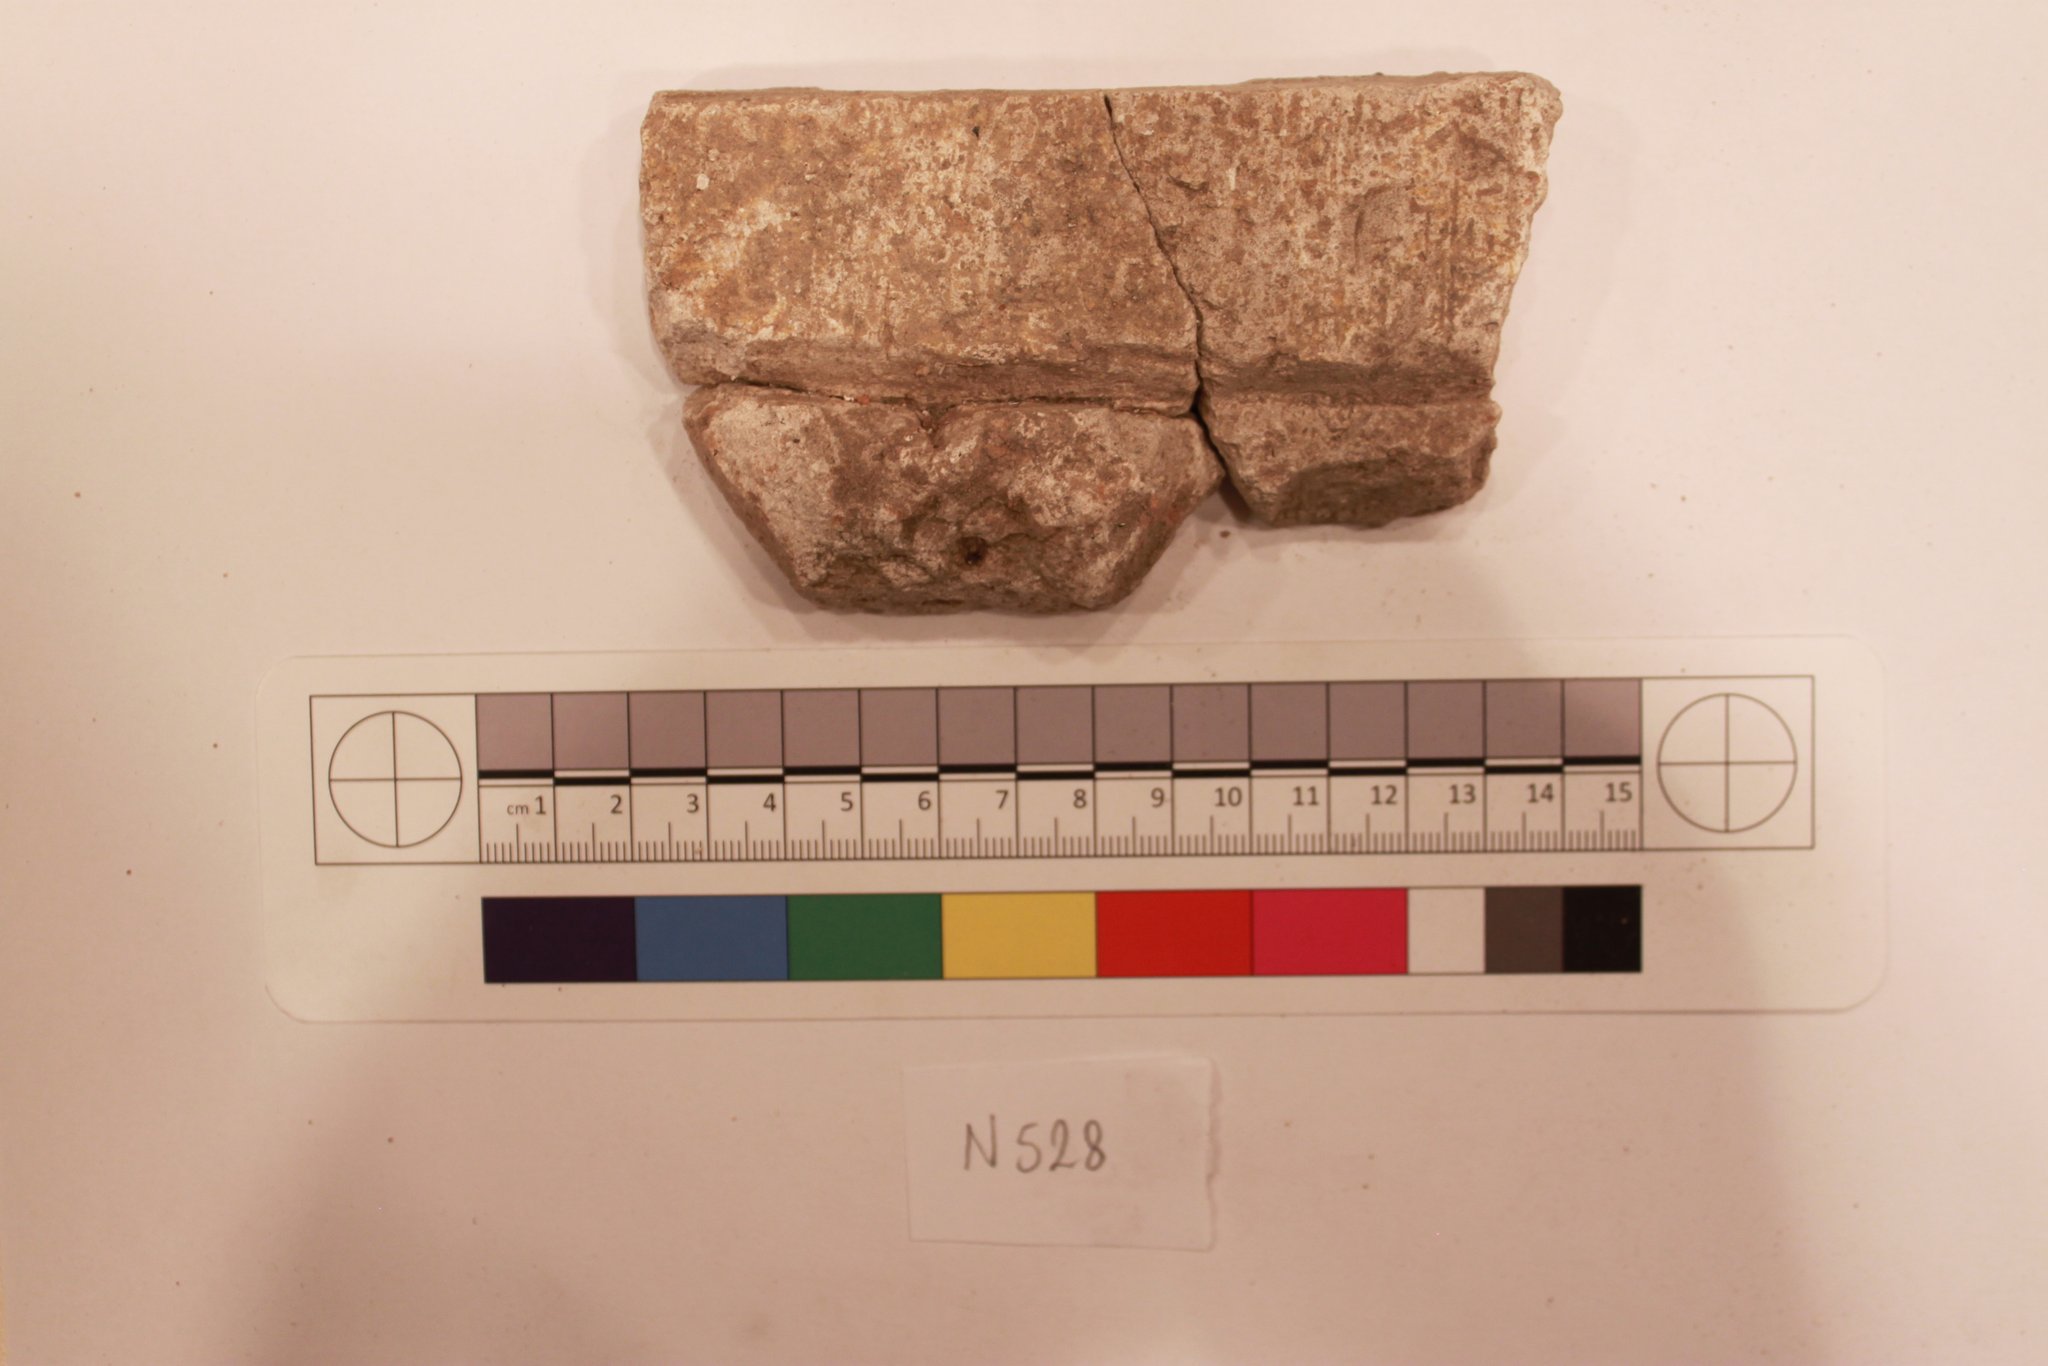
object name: fragment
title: Stucco Fragment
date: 701-1200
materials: plaster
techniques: carving, painting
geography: iran